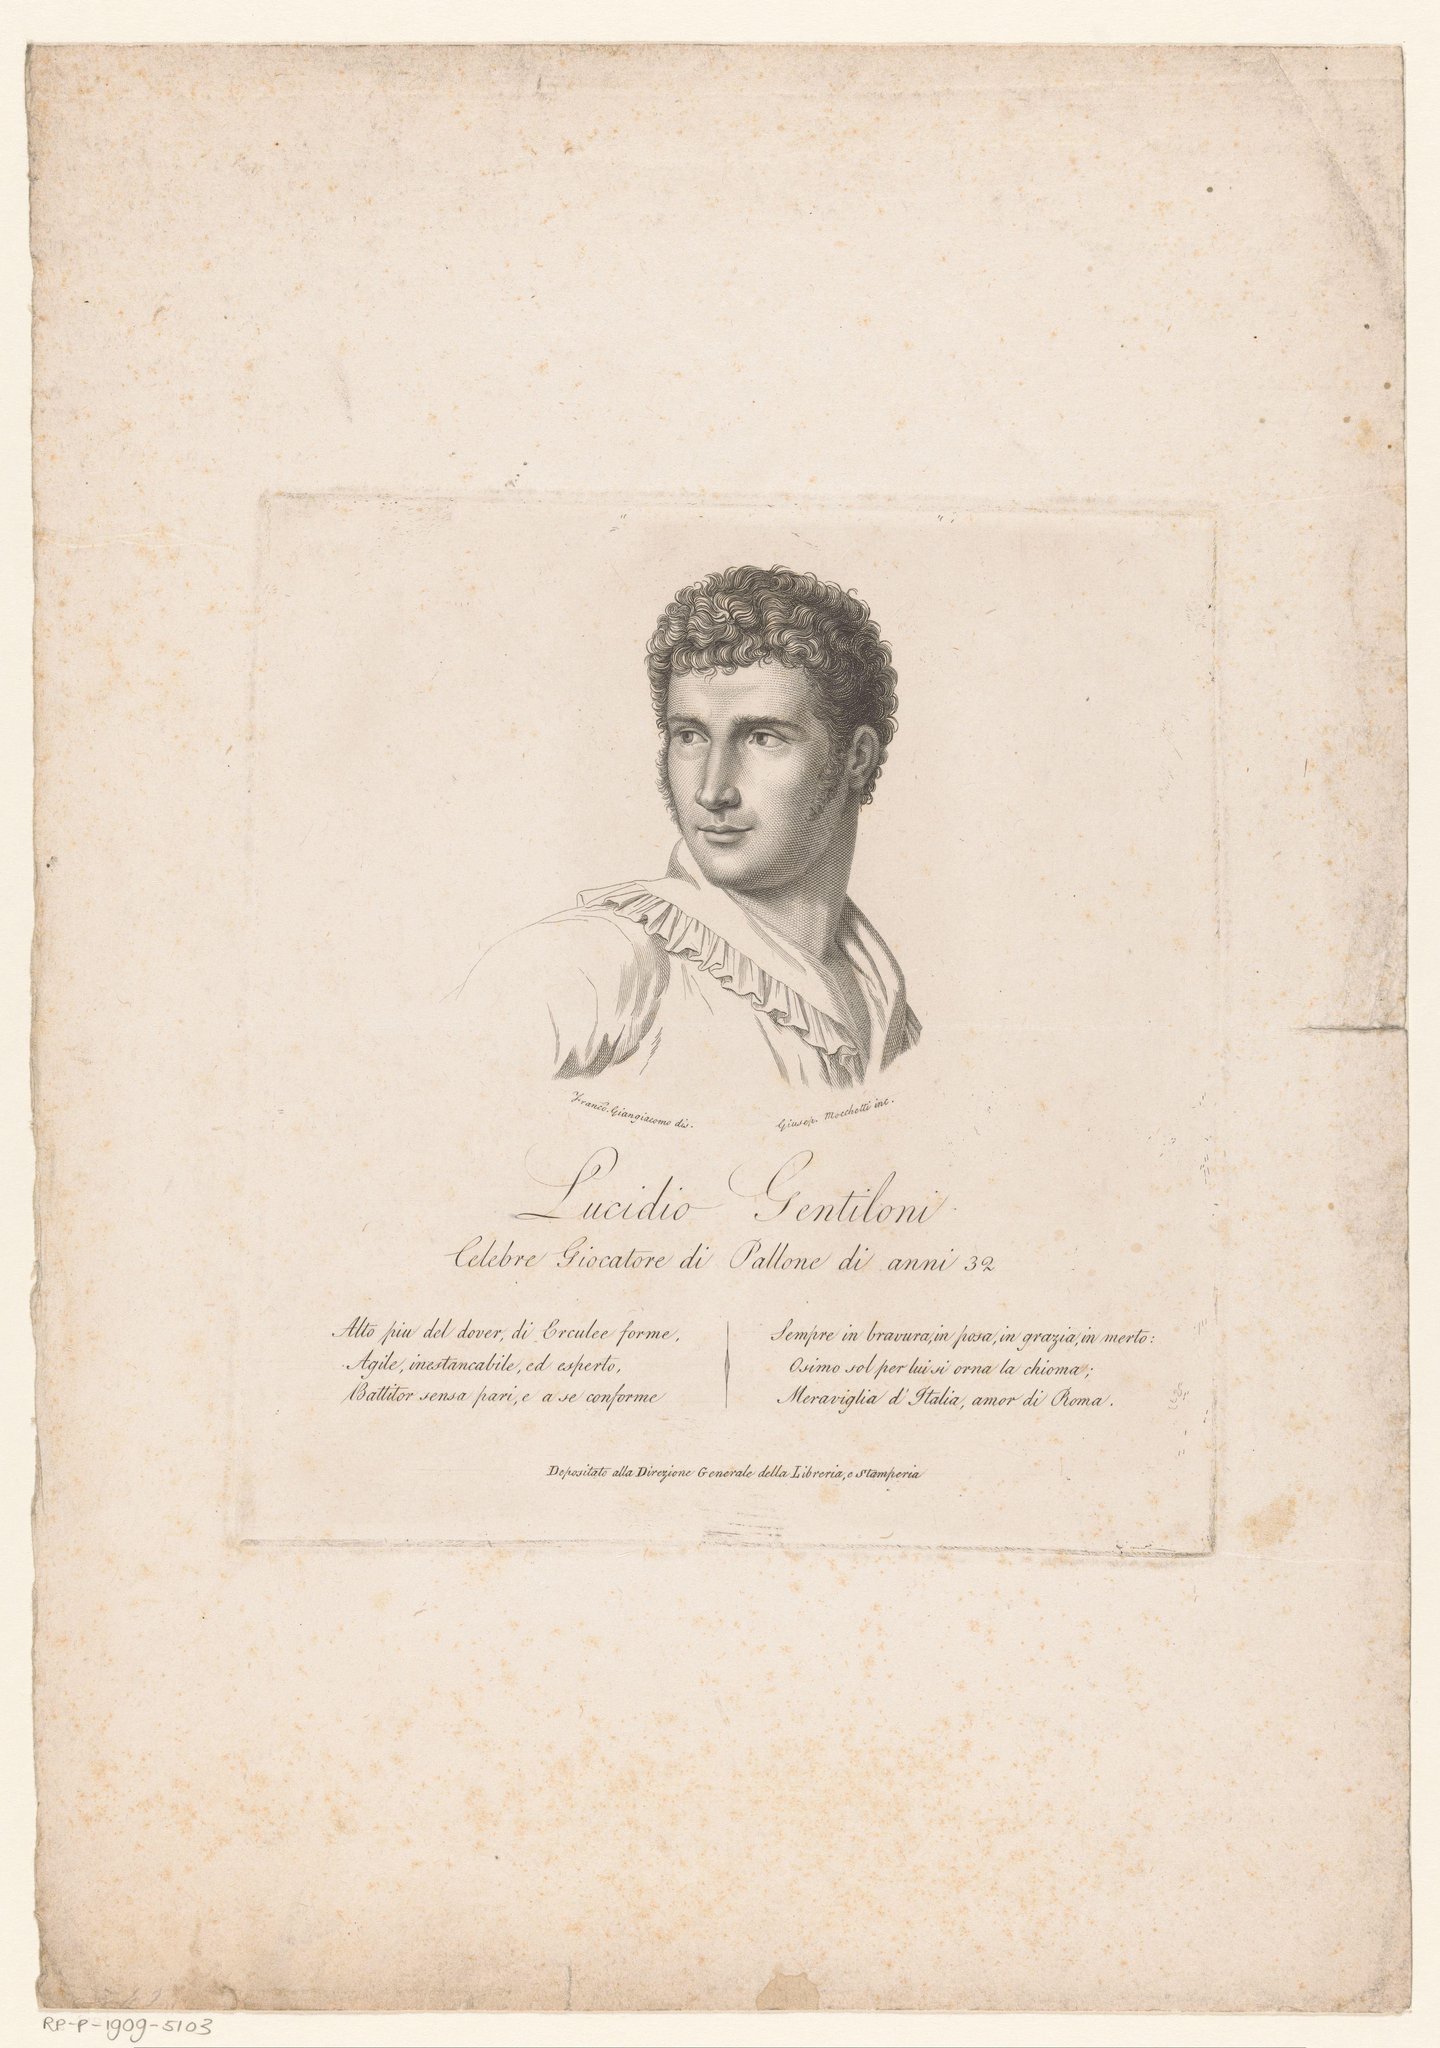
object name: print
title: Portret van voetballer Lucidio Gentiloni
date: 1909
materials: paper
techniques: engraving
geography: italy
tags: soccer, football (early names: soule, choule, cholle) (+ sportsman, player, etc.), historical persons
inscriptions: collector's mark: Lugt 2228